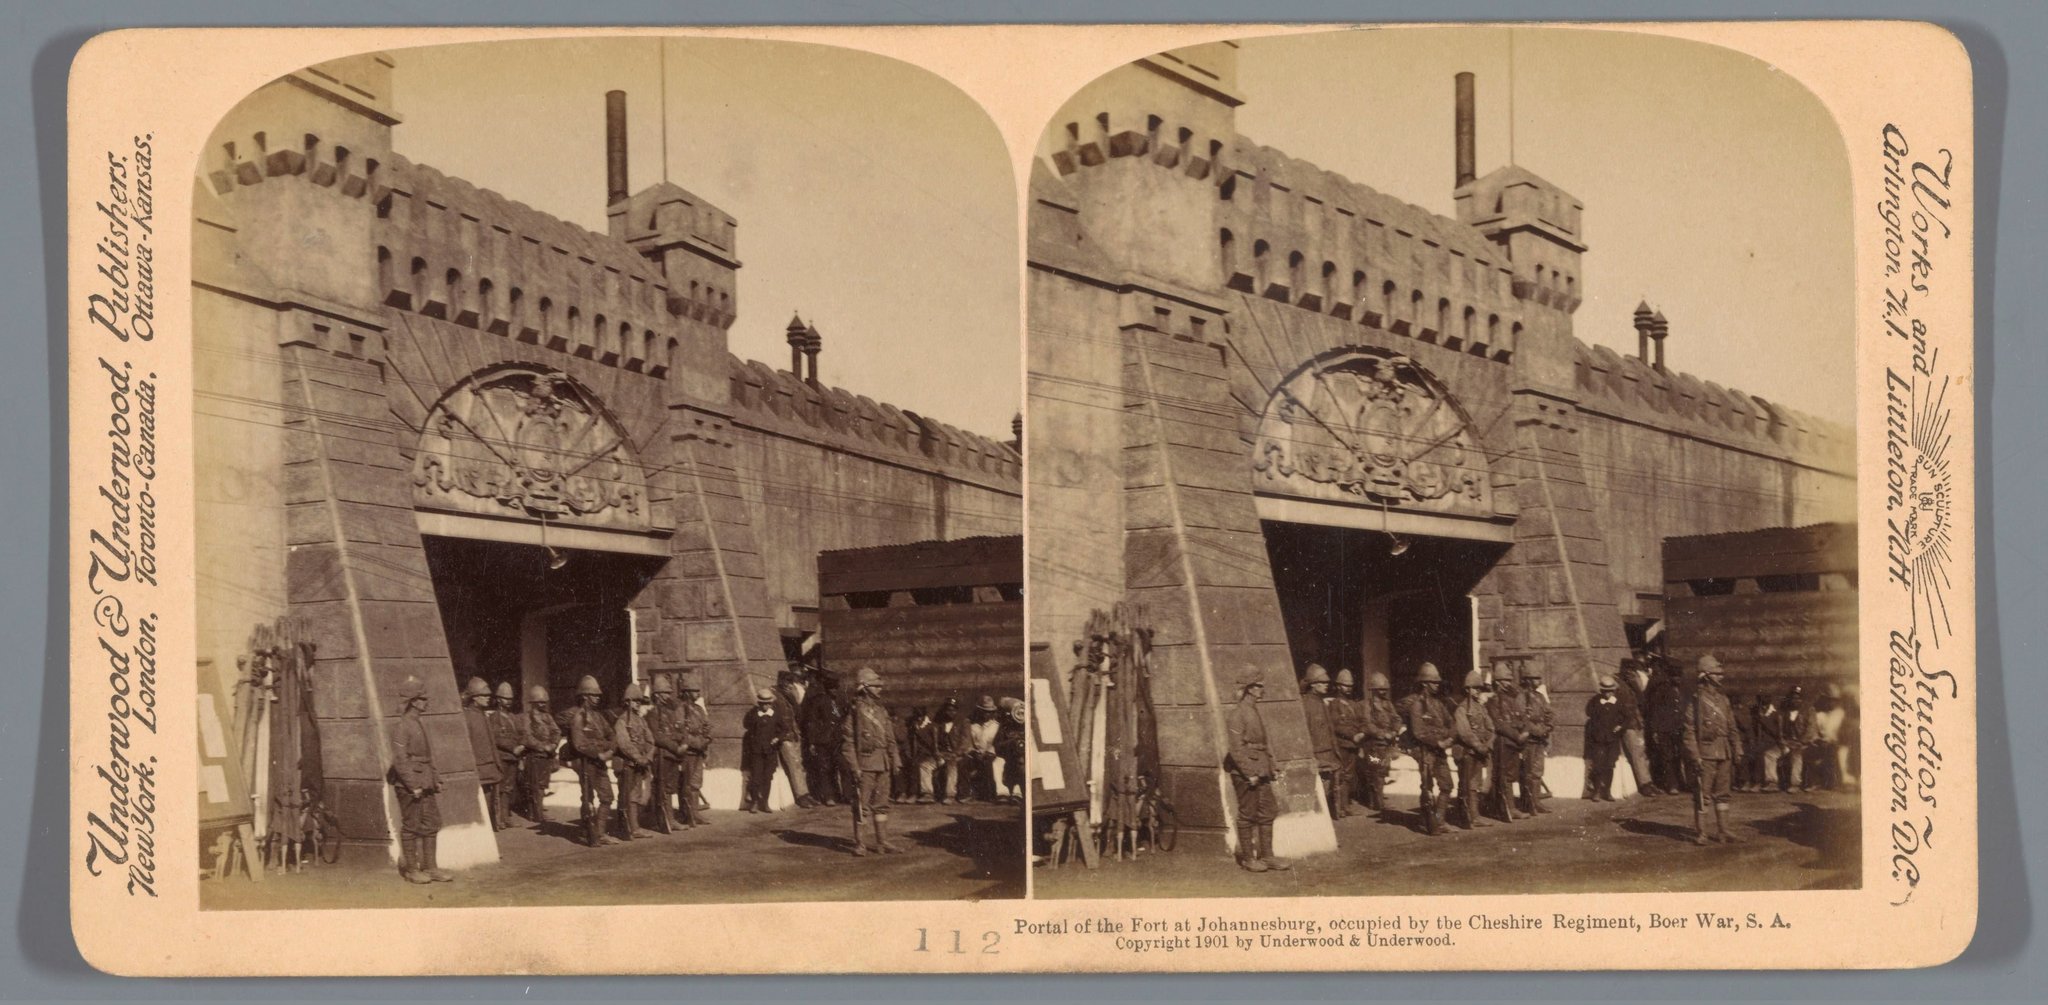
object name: stereograph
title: Portal of the Fort at Johannesburg, occupied by the Cheshire Regiment, Boer War, S. Africa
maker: Anonymous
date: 1901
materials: cardboard, paper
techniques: albumen print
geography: johannesburg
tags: prison, jail, johannesburg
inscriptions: inscription: ‘Works and Studios ~/ Arlington, N.J. Littleton, N.H. Washington, D.C.’, inscription, copyright notice: ‘Copyright 1901 by Underwood & Underwood.’, number: ‘112’